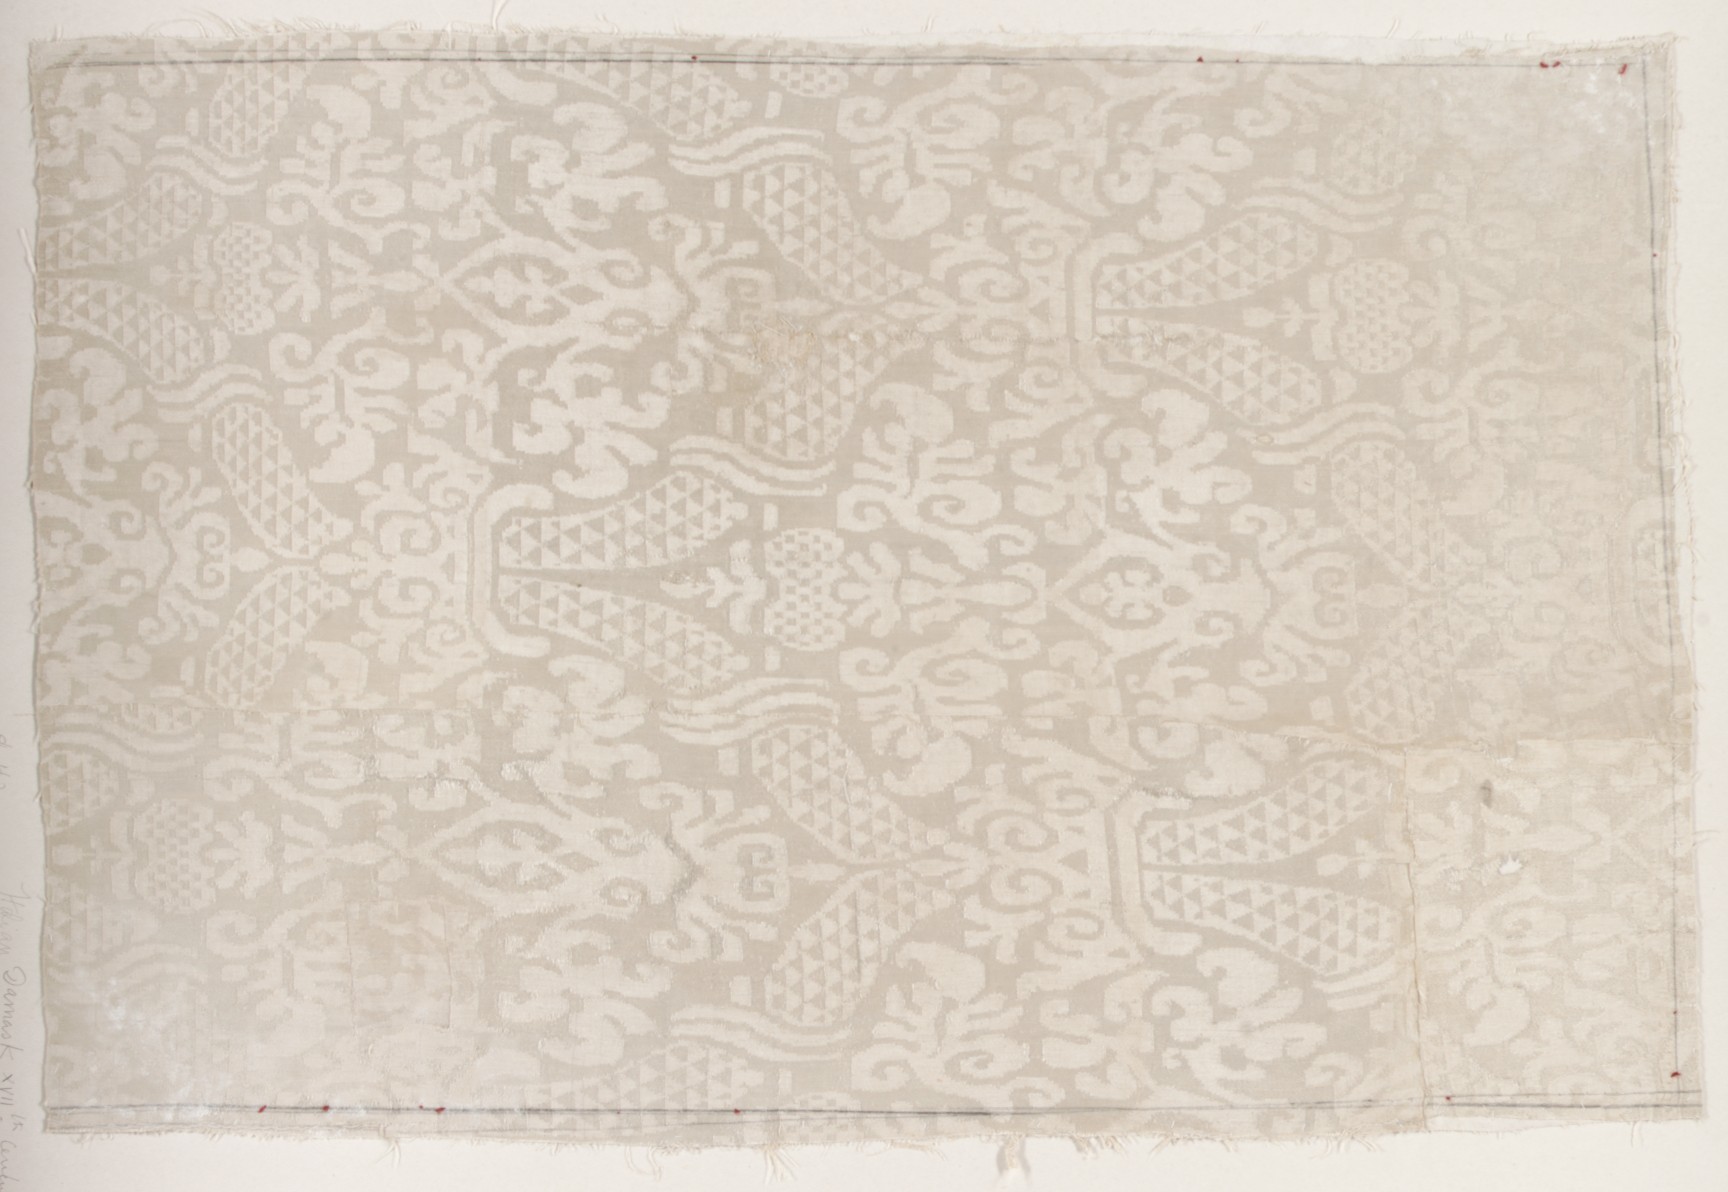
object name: fragment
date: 1601-1700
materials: silk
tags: leaves